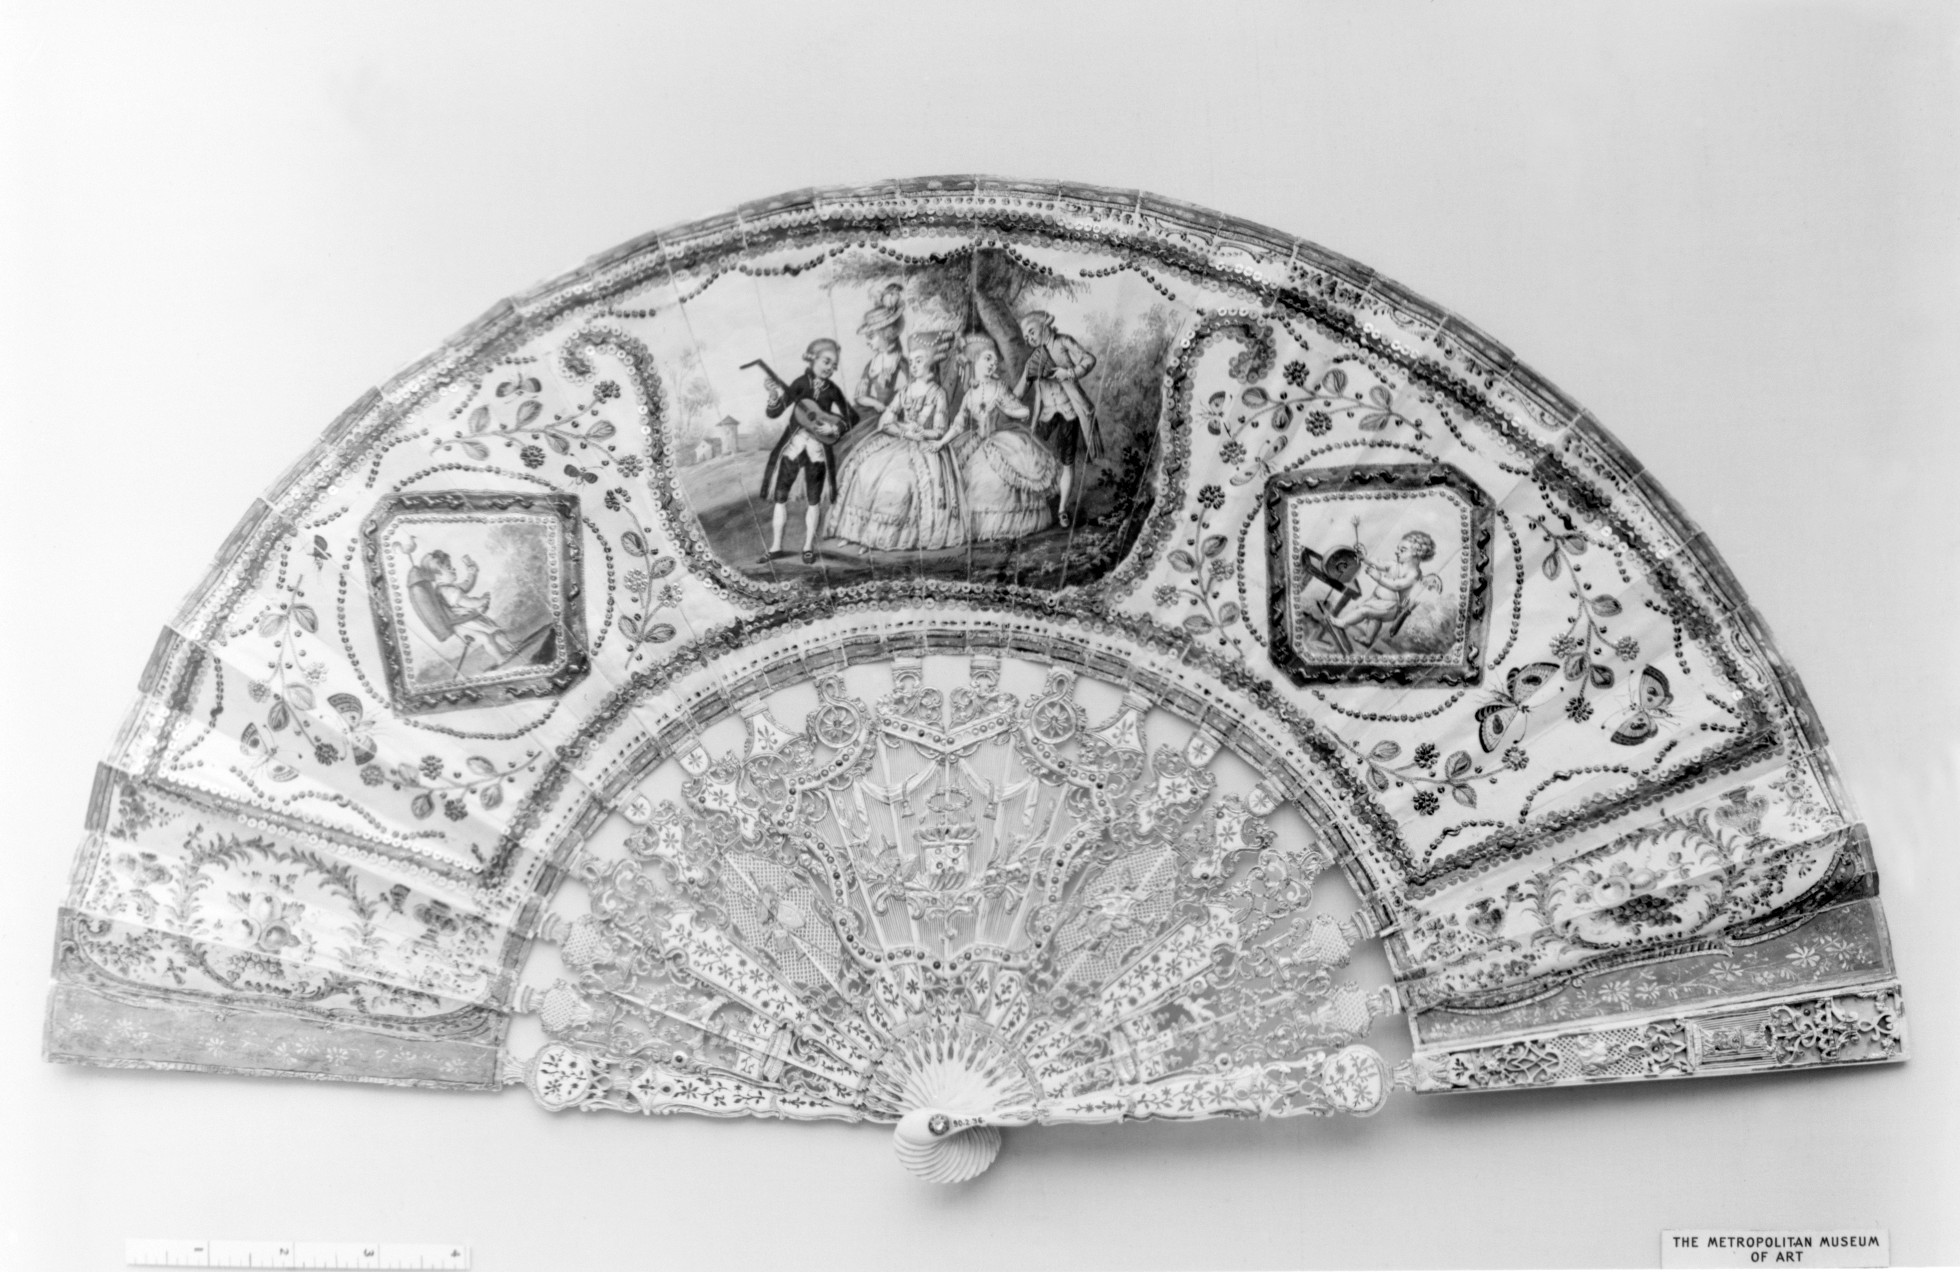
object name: fan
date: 1775-1777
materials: ivory, silk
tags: musical instruments,men,women,cupid